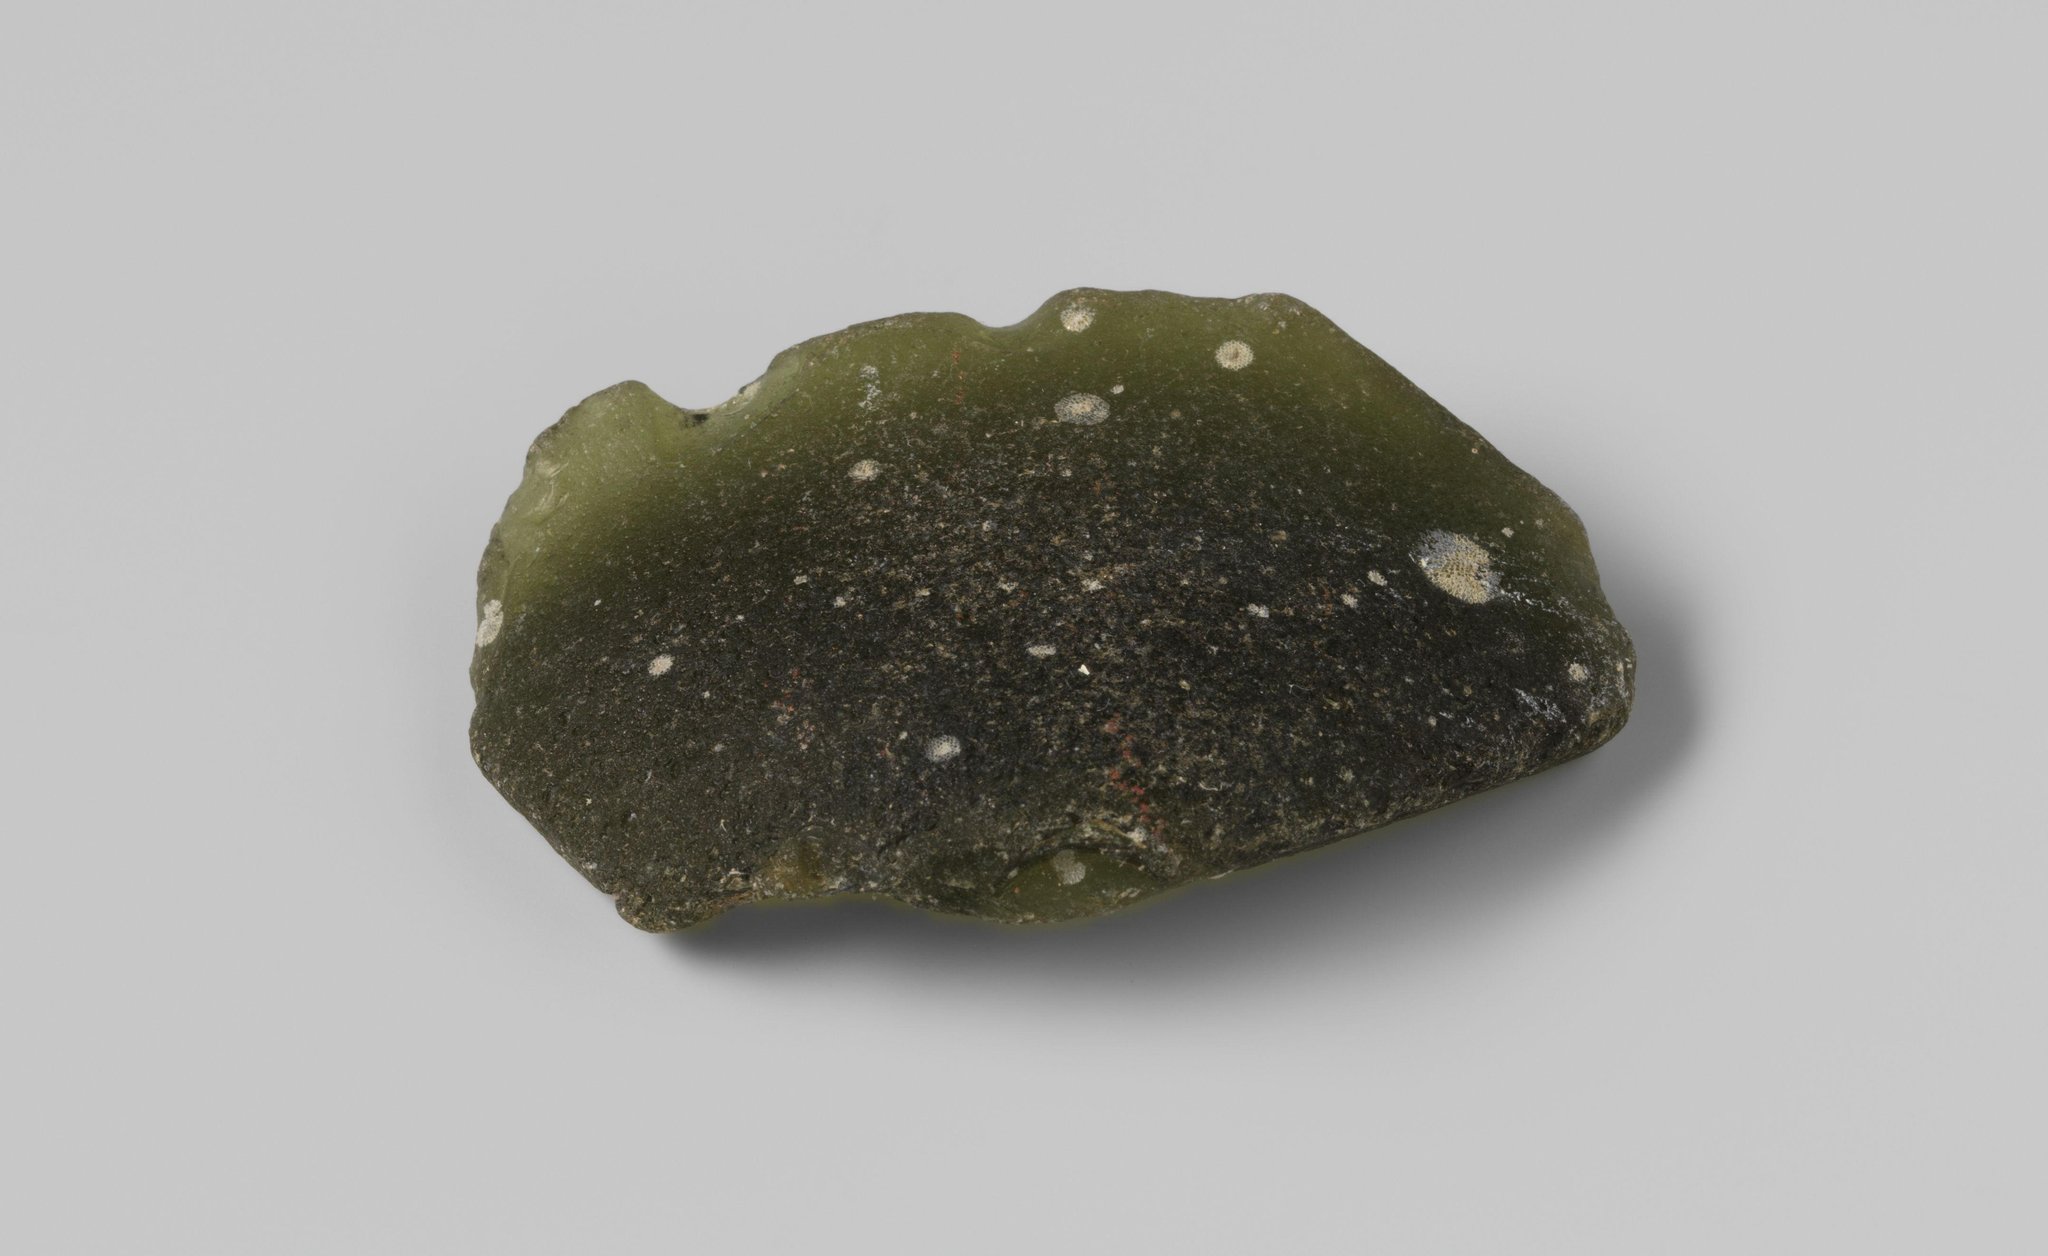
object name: wine bottle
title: Scherf van een wijnfles uit het wrak van de Oostindiëvaarder Hollandia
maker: Anonymous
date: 1700-1743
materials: glass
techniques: green glass